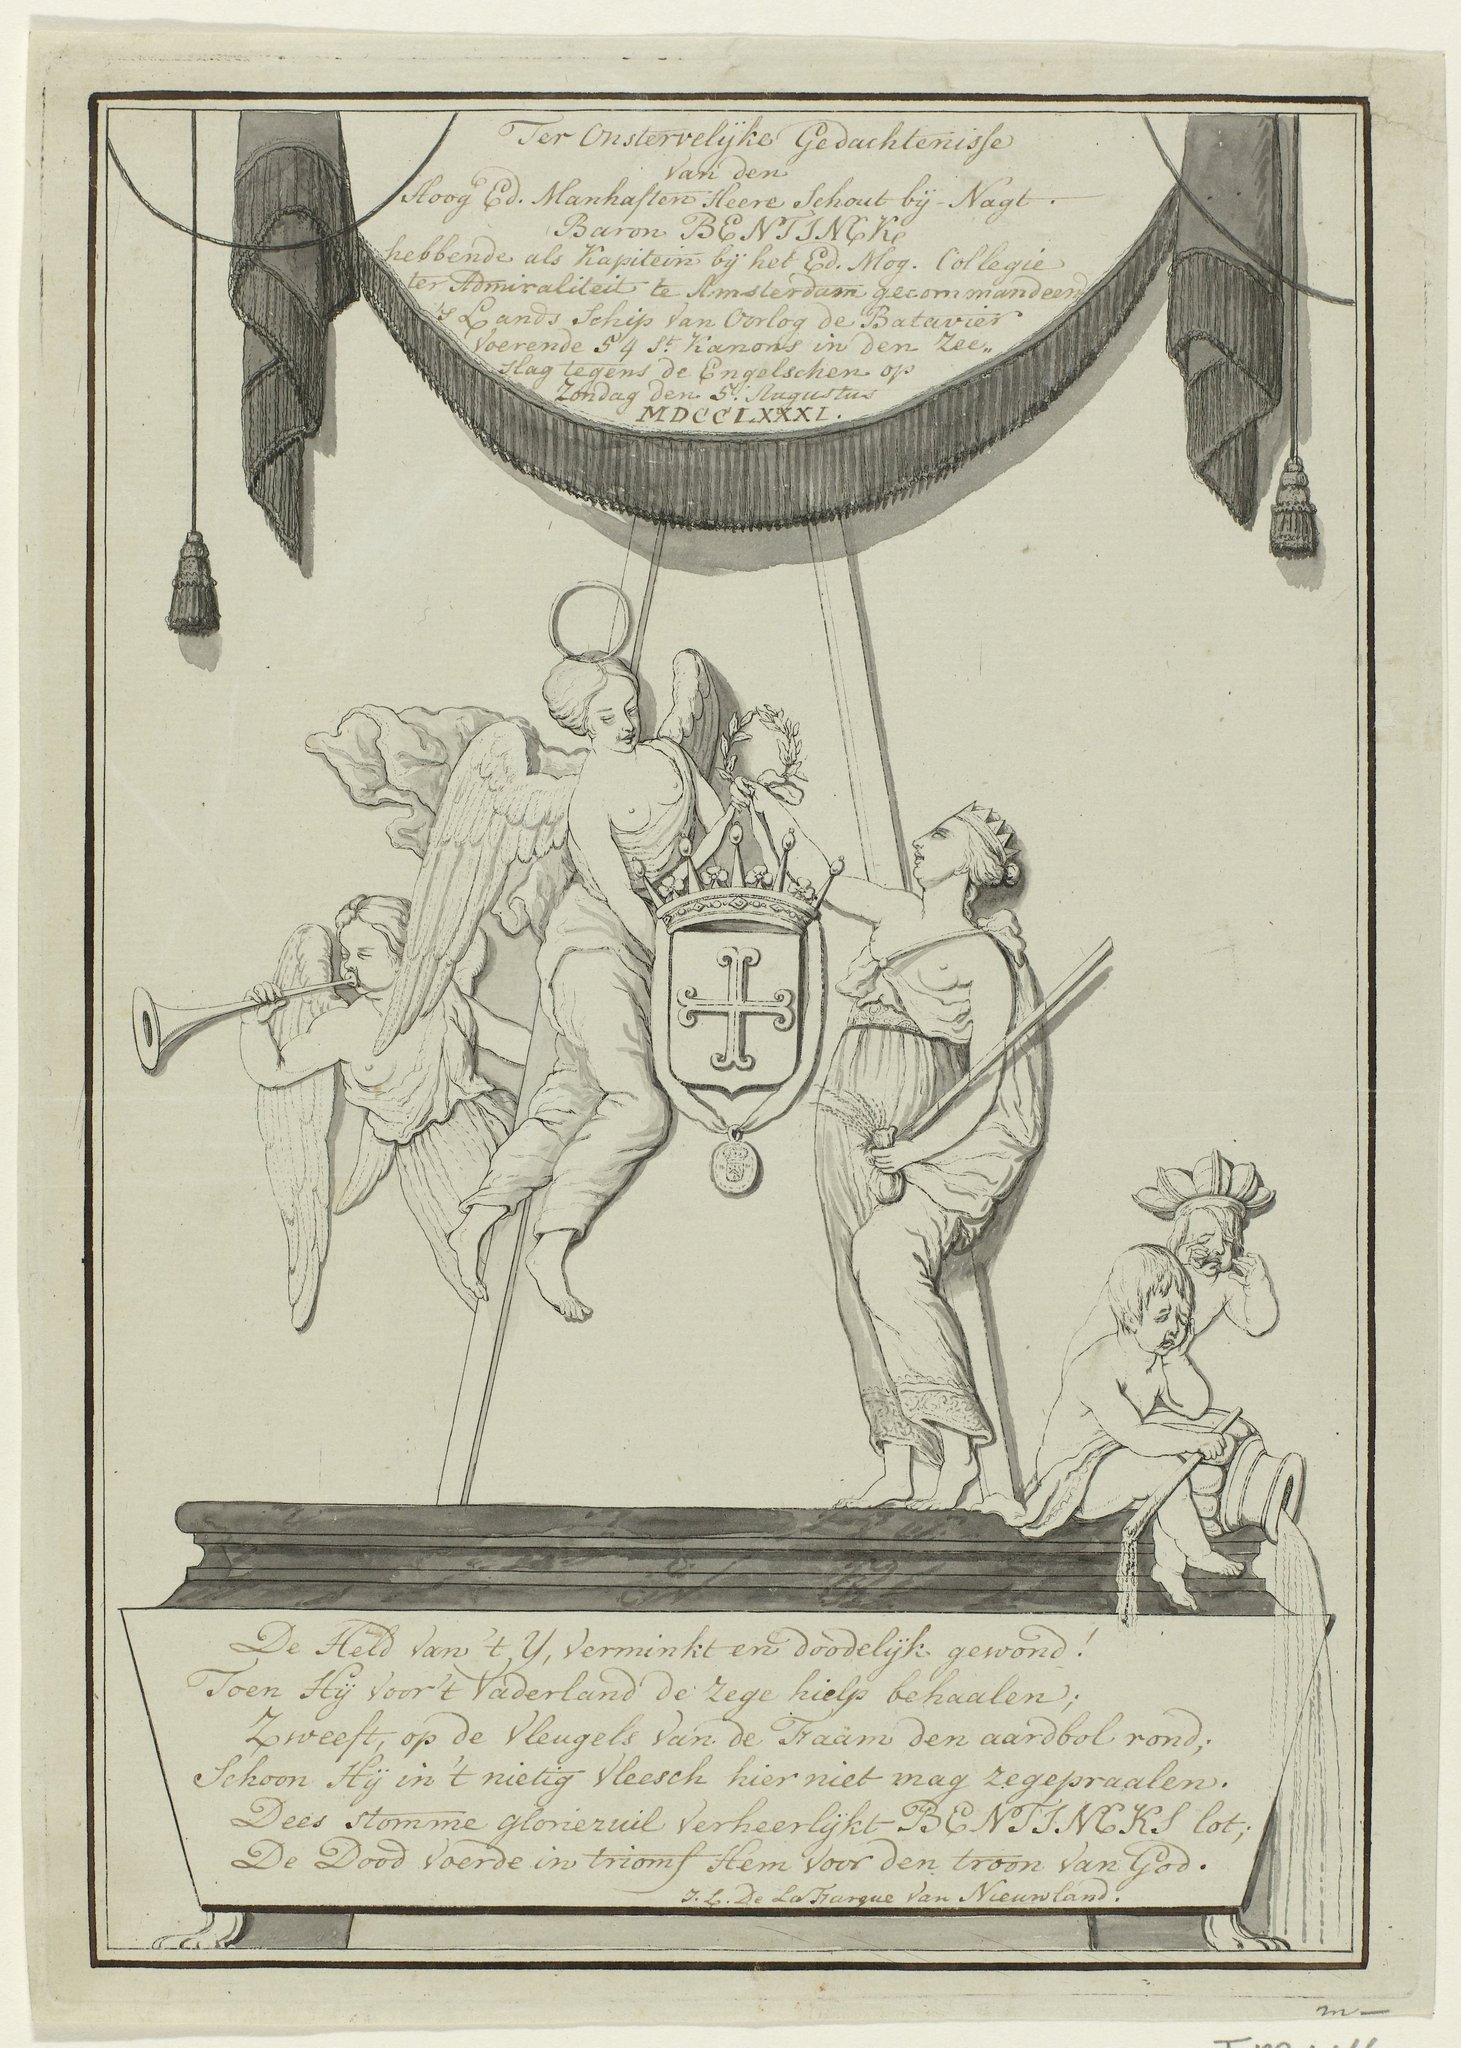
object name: print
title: Ontwerp voor gedenkteken bij het graf van Wolter Jan Gerrit baron Bentinck, 1781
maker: isaac lodewijk la fargue van nieuwland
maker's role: draughtsman, painter, print maker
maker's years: 1726-1805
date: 1781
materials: paper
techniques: brush, etching, pen, writing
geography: northern netherlands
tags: amsterdam, grave-building, monumental tomb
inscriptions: collector's mark: Lugt 2228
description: Niet uitgevoerd ontwerp voor een allegorisch gedenkteken boven het graf van Wolter Jan Gerrit baron Bentinck, begraven op 28 augustus 1781 in de Nieuwe Kerk te Amsterdam. Voorstelling in etsdruk opgetekend met pen en penseel en met een handgeschreven zesregelig vers op de tombe.